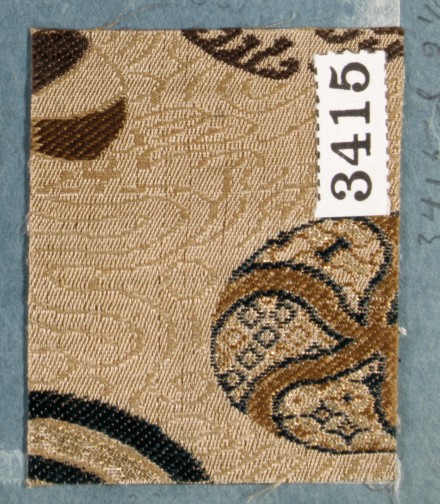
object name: textile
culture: japanese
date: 1801-1900